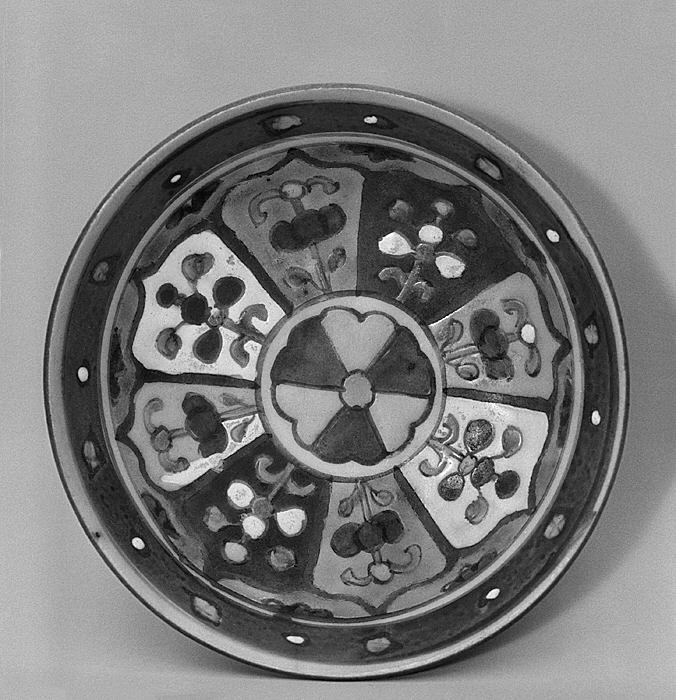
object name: saucer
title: Saucer with floral pattern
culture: chinese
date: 1801-1900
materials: enamel, porcelain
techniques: overglaze, painting, polychrome